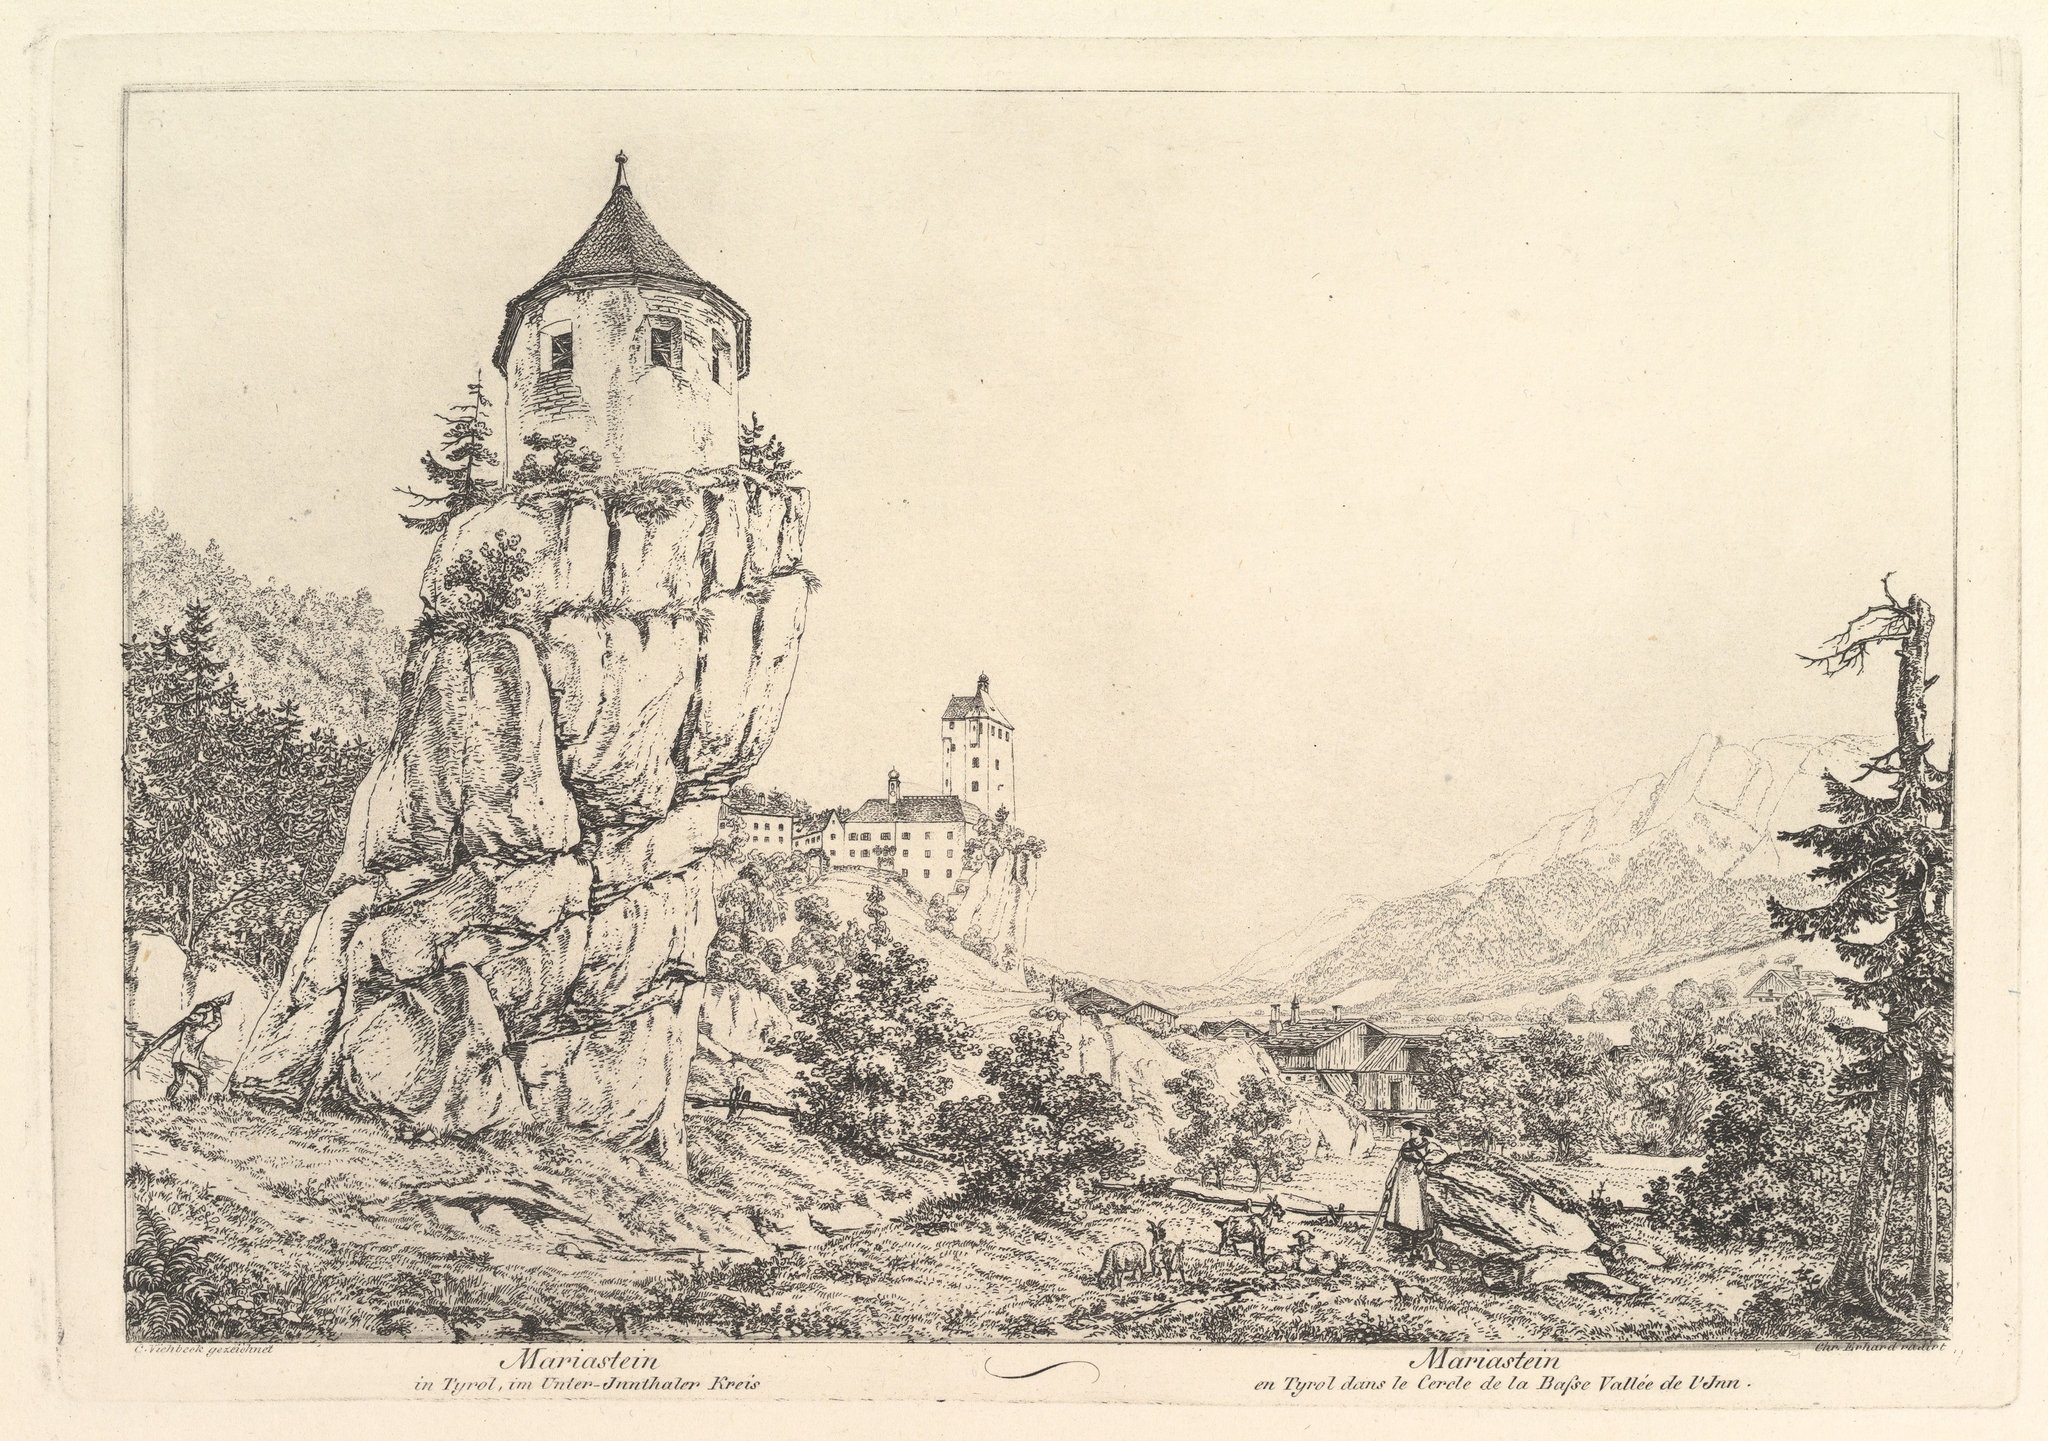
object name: print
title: Landscape, Mariastein in Tyrol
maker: johann christoph erhard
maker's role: artist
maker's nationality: german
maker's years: 1795-1822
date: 1801-1833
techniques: etching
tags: buildings,landscapes